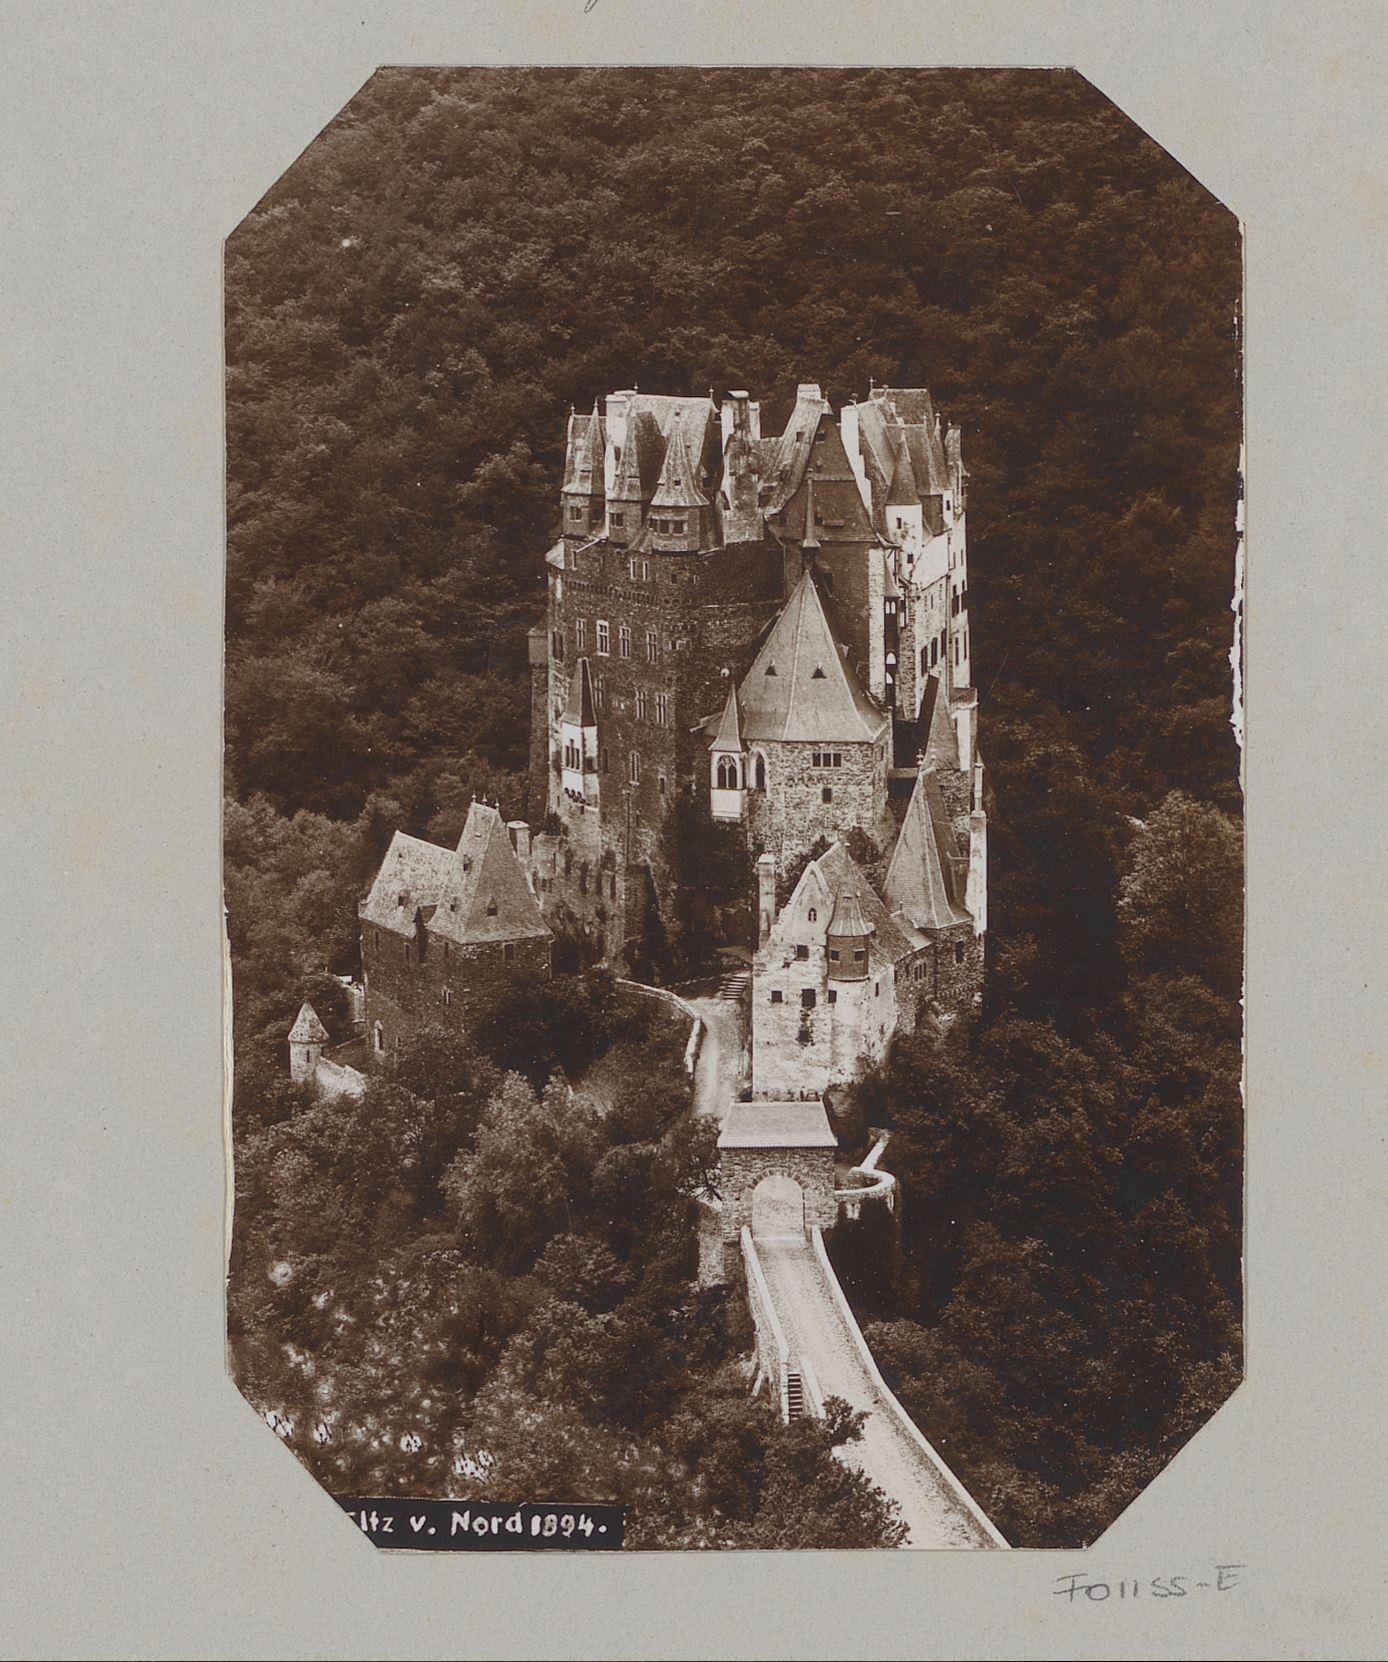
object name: album leaf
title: Gezicht op de noordzijde van Burg Eltz te Wierschem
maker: Anonymous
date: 1894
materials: photographic support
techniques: collodion silver print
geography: wierschem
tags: landscape with tower or castle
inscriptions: inscription: ‘Burg Eltz v. Nord 1894’, annotation: ‘Burg Eltz’